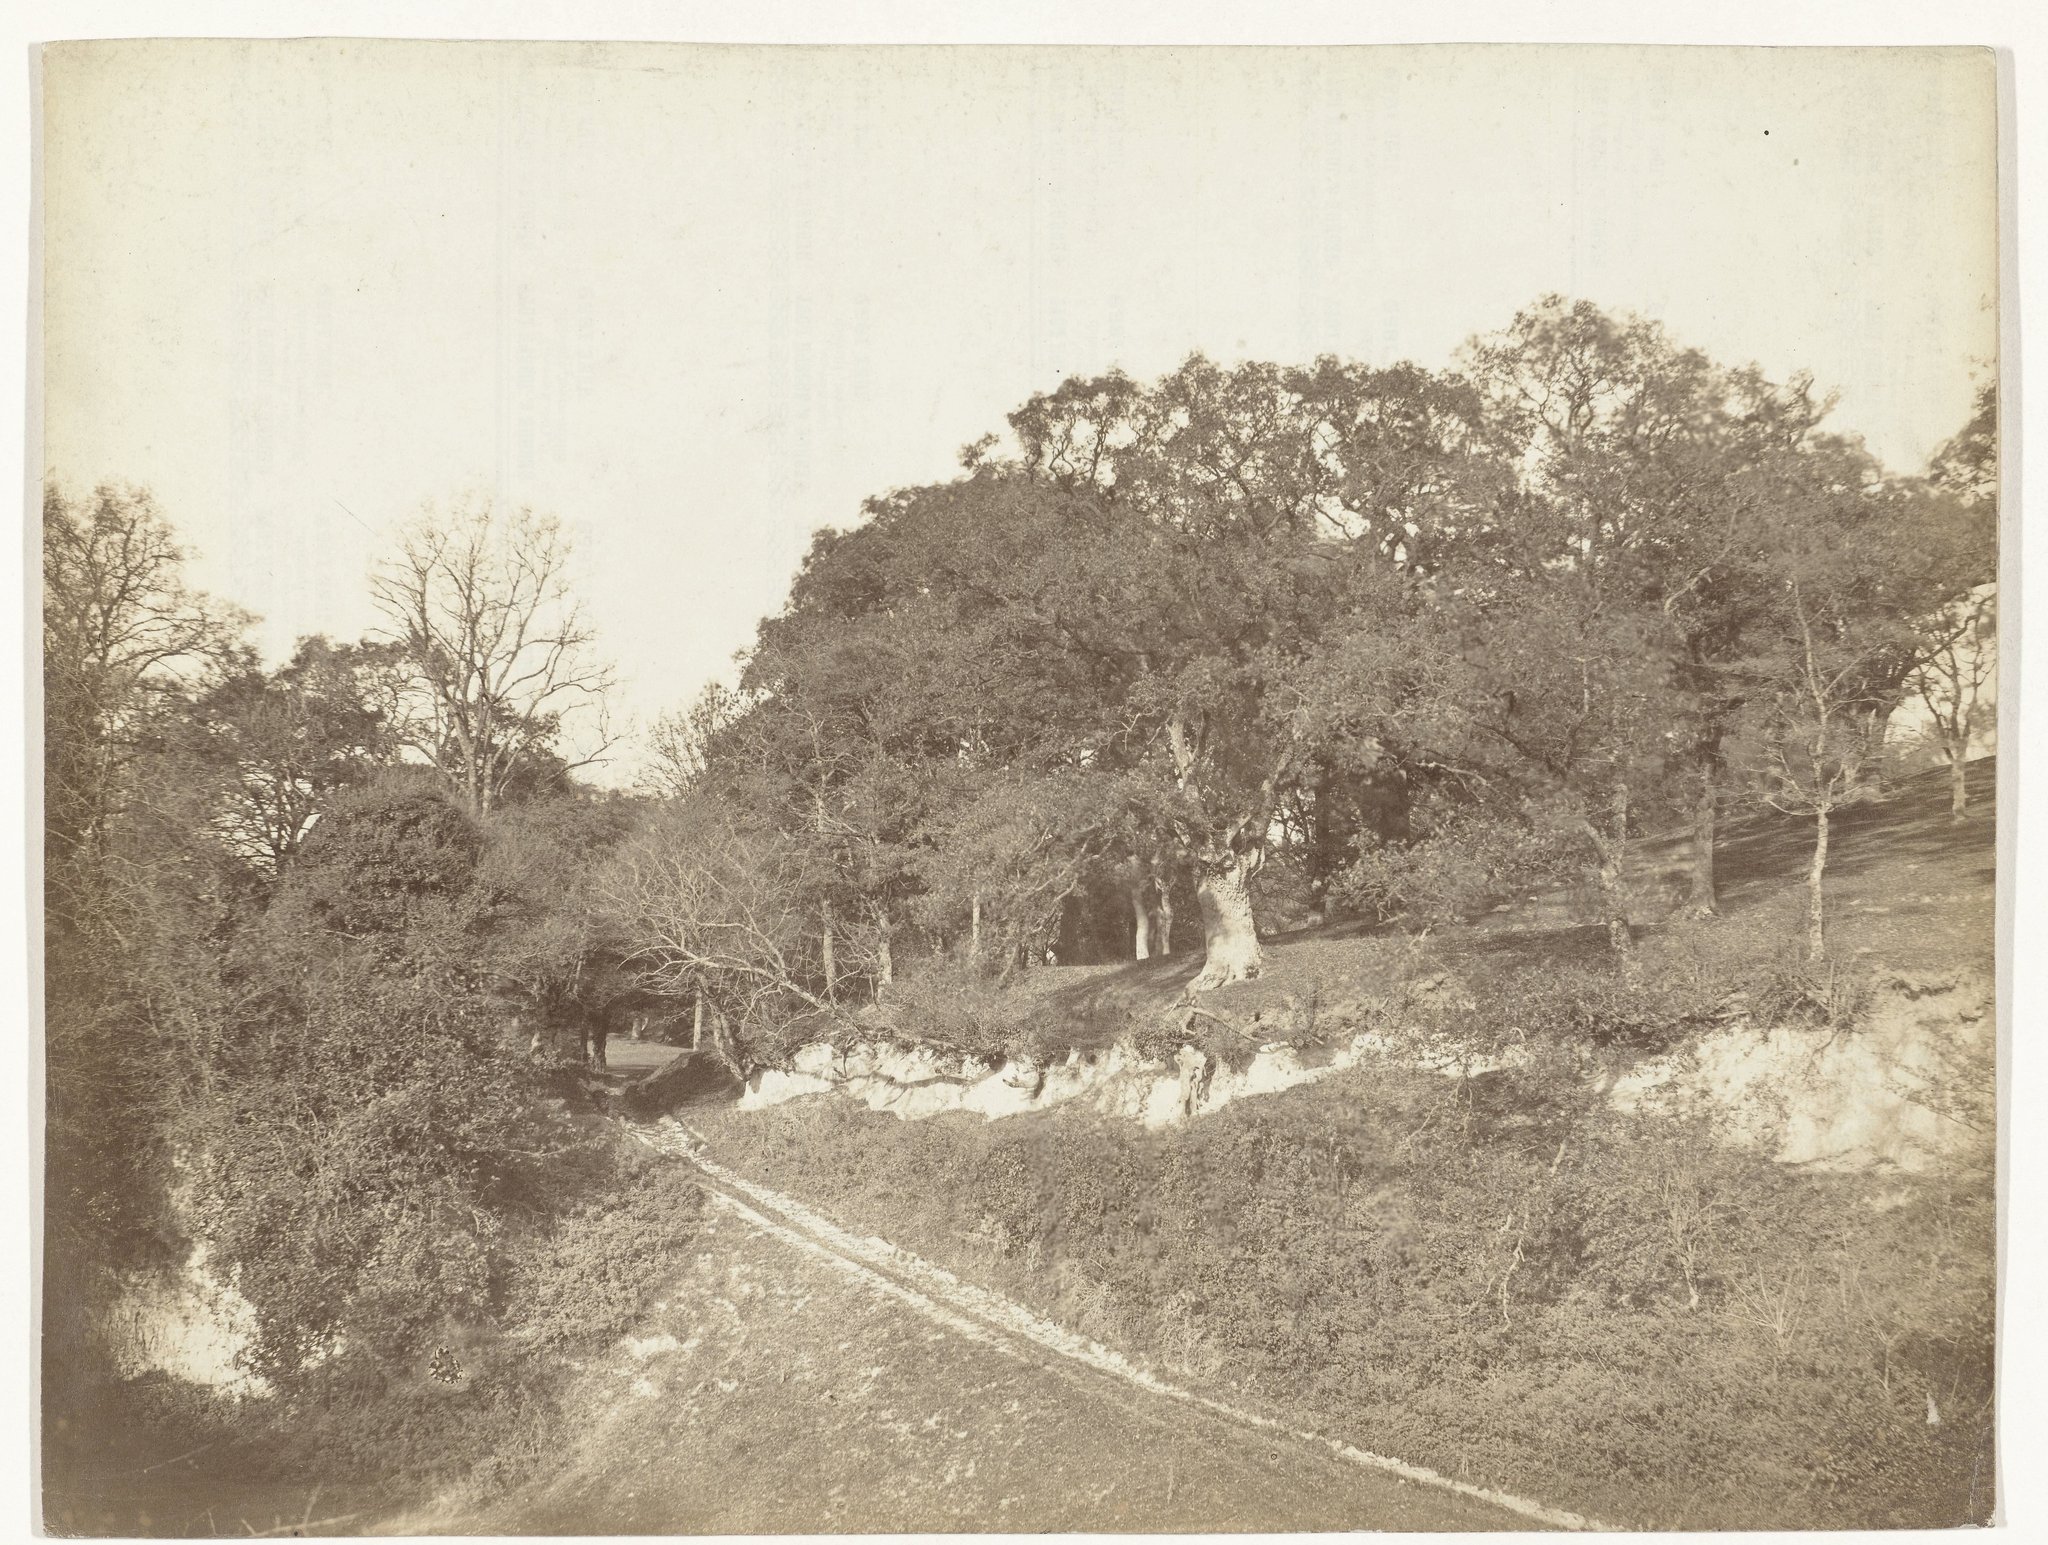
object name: photograph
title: Voetpad door een landschap met bomen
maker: Anonymous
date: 1859-1860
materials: paper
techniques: albumen print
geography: great britain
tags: forest path or lane, great britain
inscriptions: watermark: ‘GEORGE & JOSEPH LOTT/ [...]/ Silent Street, Ipswich/ JUNE 1859’